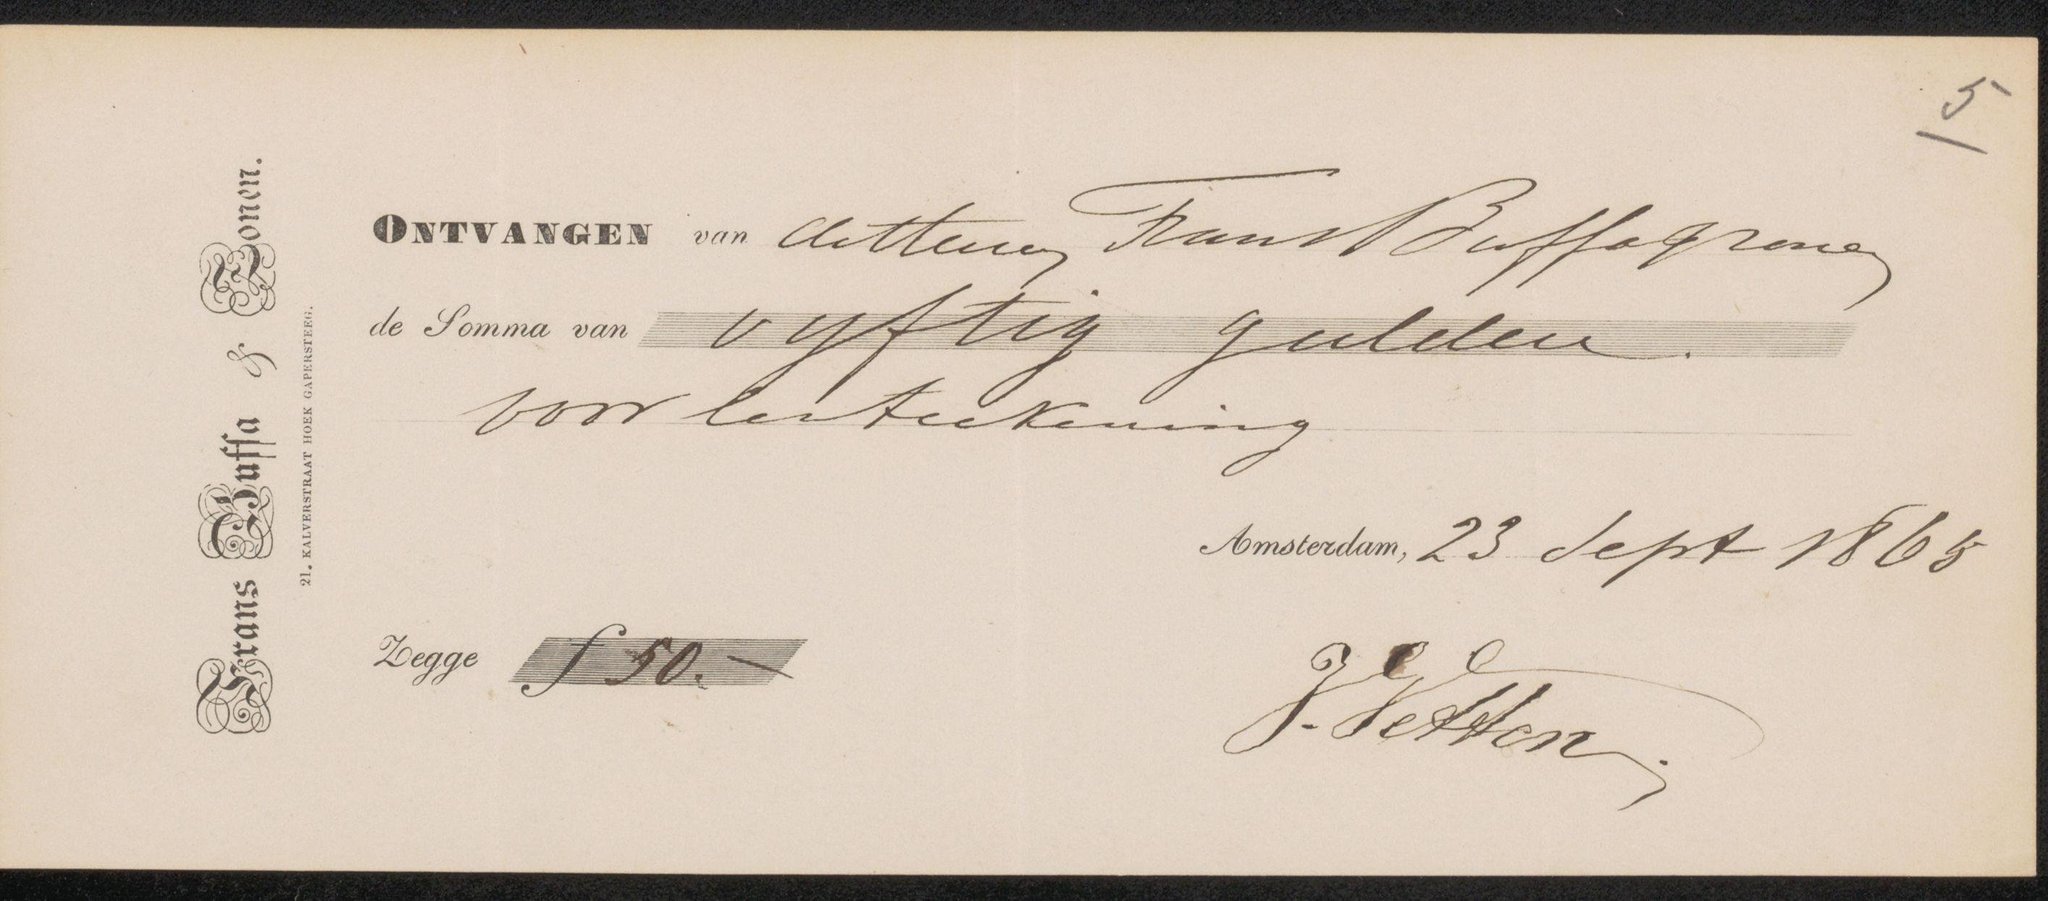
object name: ontvangstbewijs, kwitantie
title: Kwitantie voor Johannes Vetten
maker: johannes vetten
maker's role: painter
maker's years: 1827-1866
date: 1865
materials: ink, paper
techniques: pen, printing, writing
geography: amsterdam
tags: drawing, money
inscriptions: collector's mark: Lugt 2233